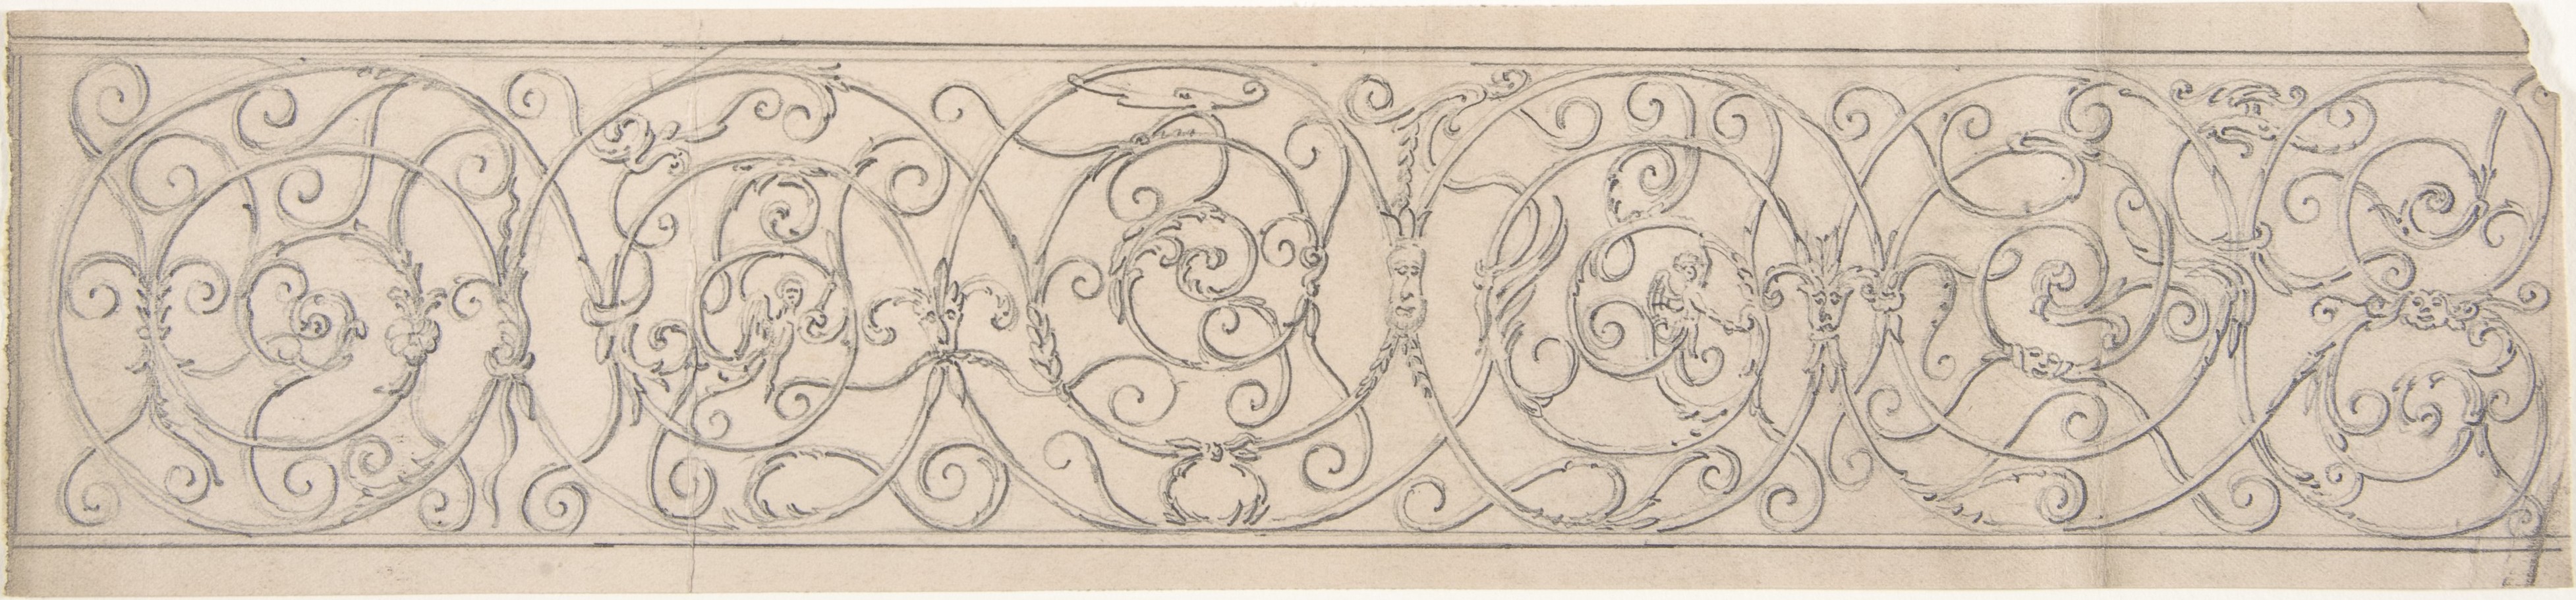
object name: drawing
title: Panel of Curvilinear Metal Ornament Adorned with Masks and Winged Figures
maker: anonymous, british, 19th century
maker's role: artist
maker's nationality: british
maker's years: 1800-1900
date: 1851-1900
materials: graphite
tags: faces